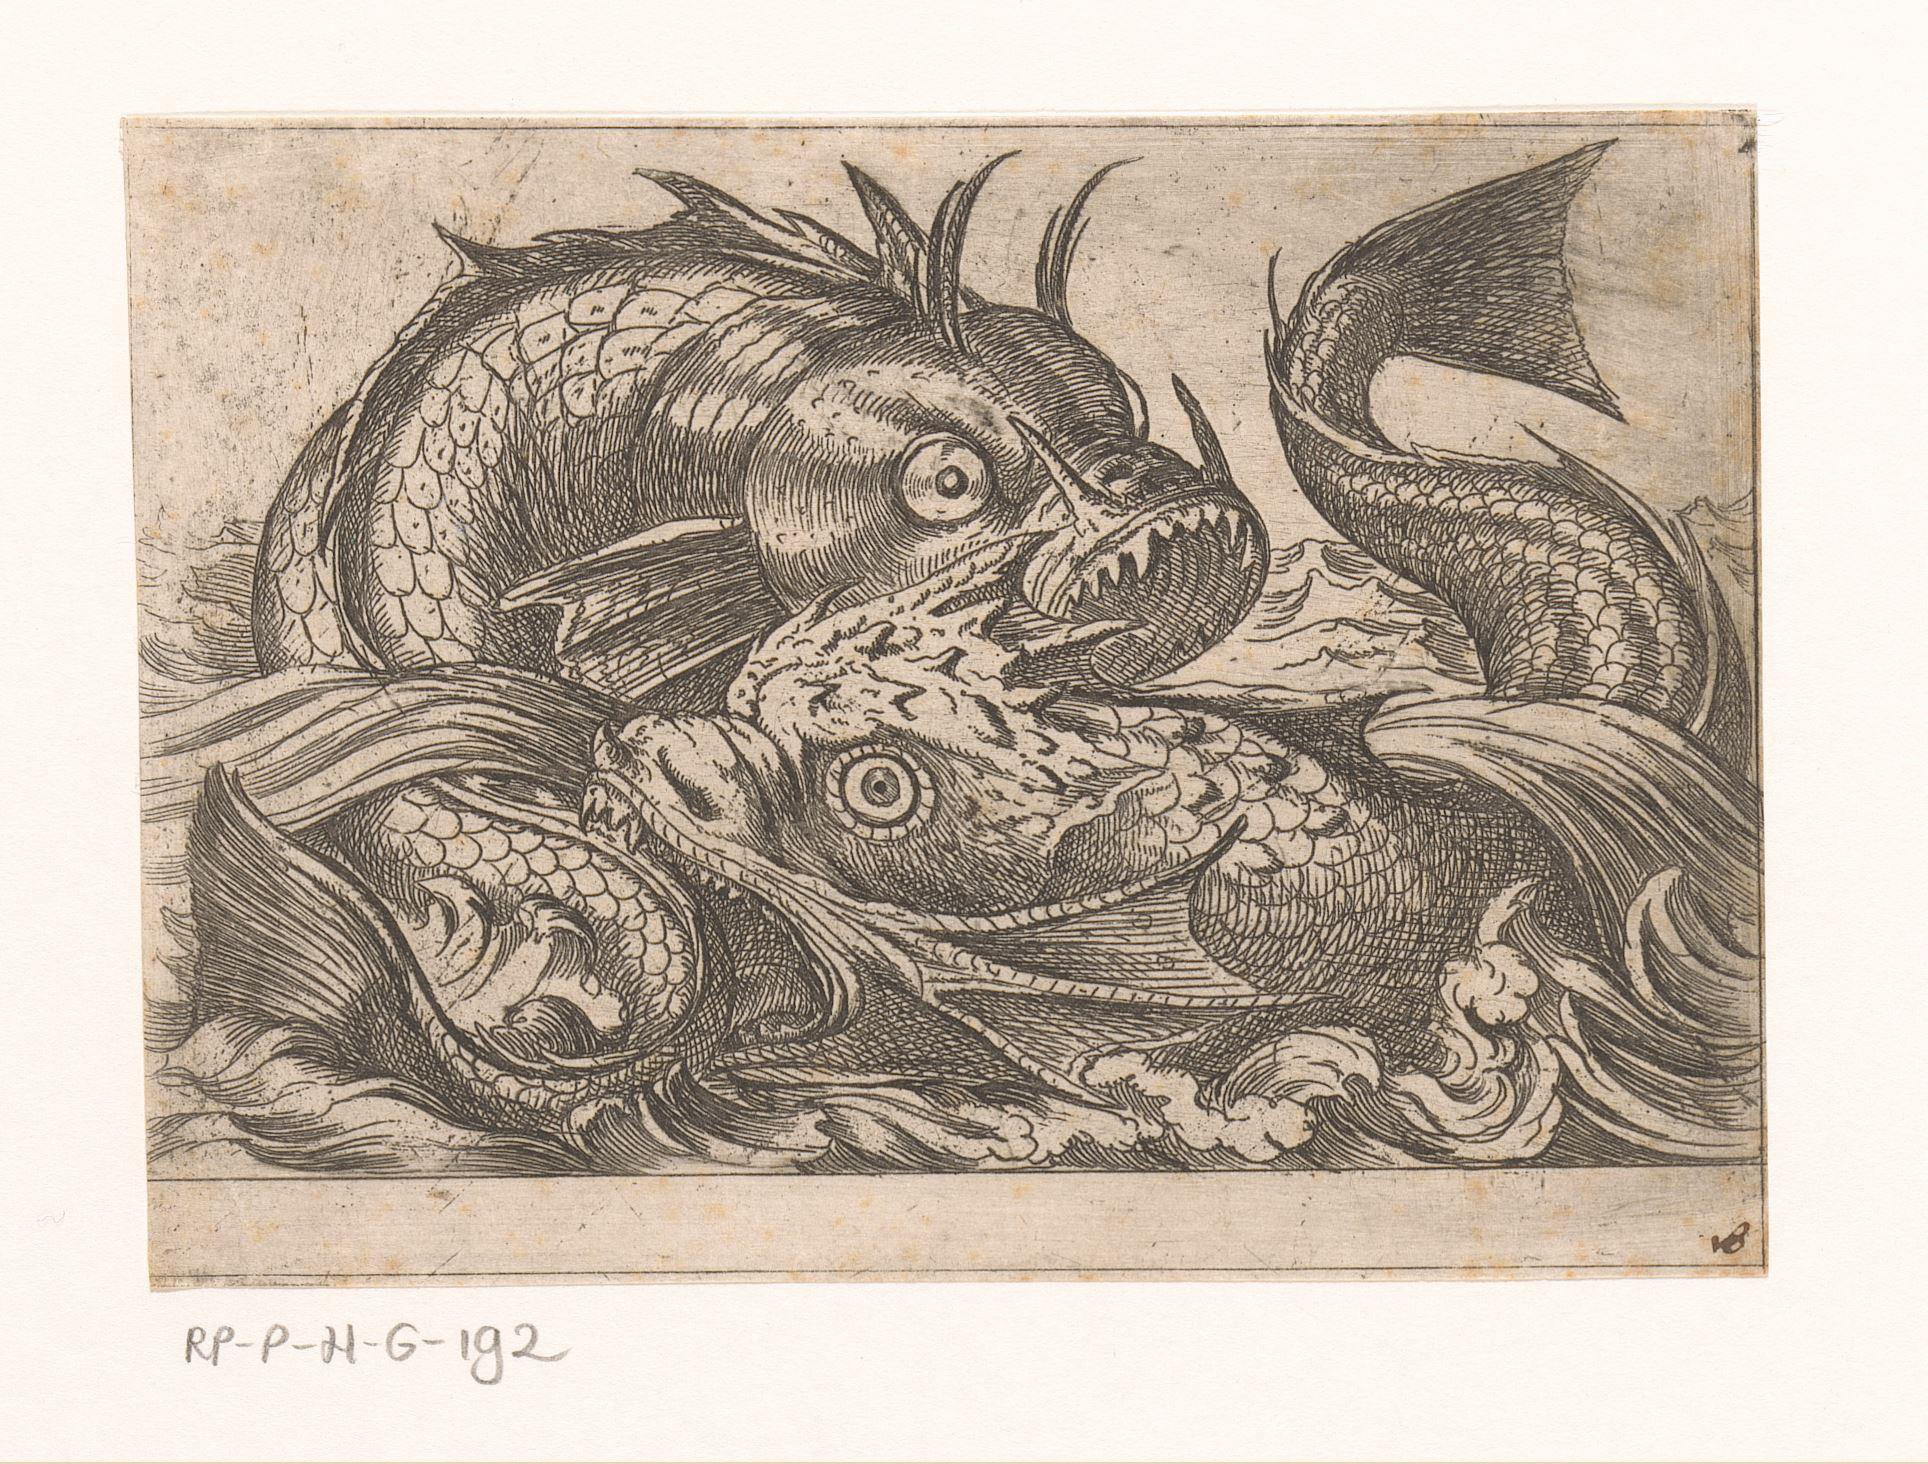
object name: print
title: Twee vechtende vissen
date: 1600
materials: paper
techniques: etching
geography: rome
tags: fishes, fighting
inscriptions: collector's mark: Lugt 2228, number: ‘18’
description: Deze prent maakt deel uit van een reeks van 25 prenten (+ titelprent) van vechtende dieren.